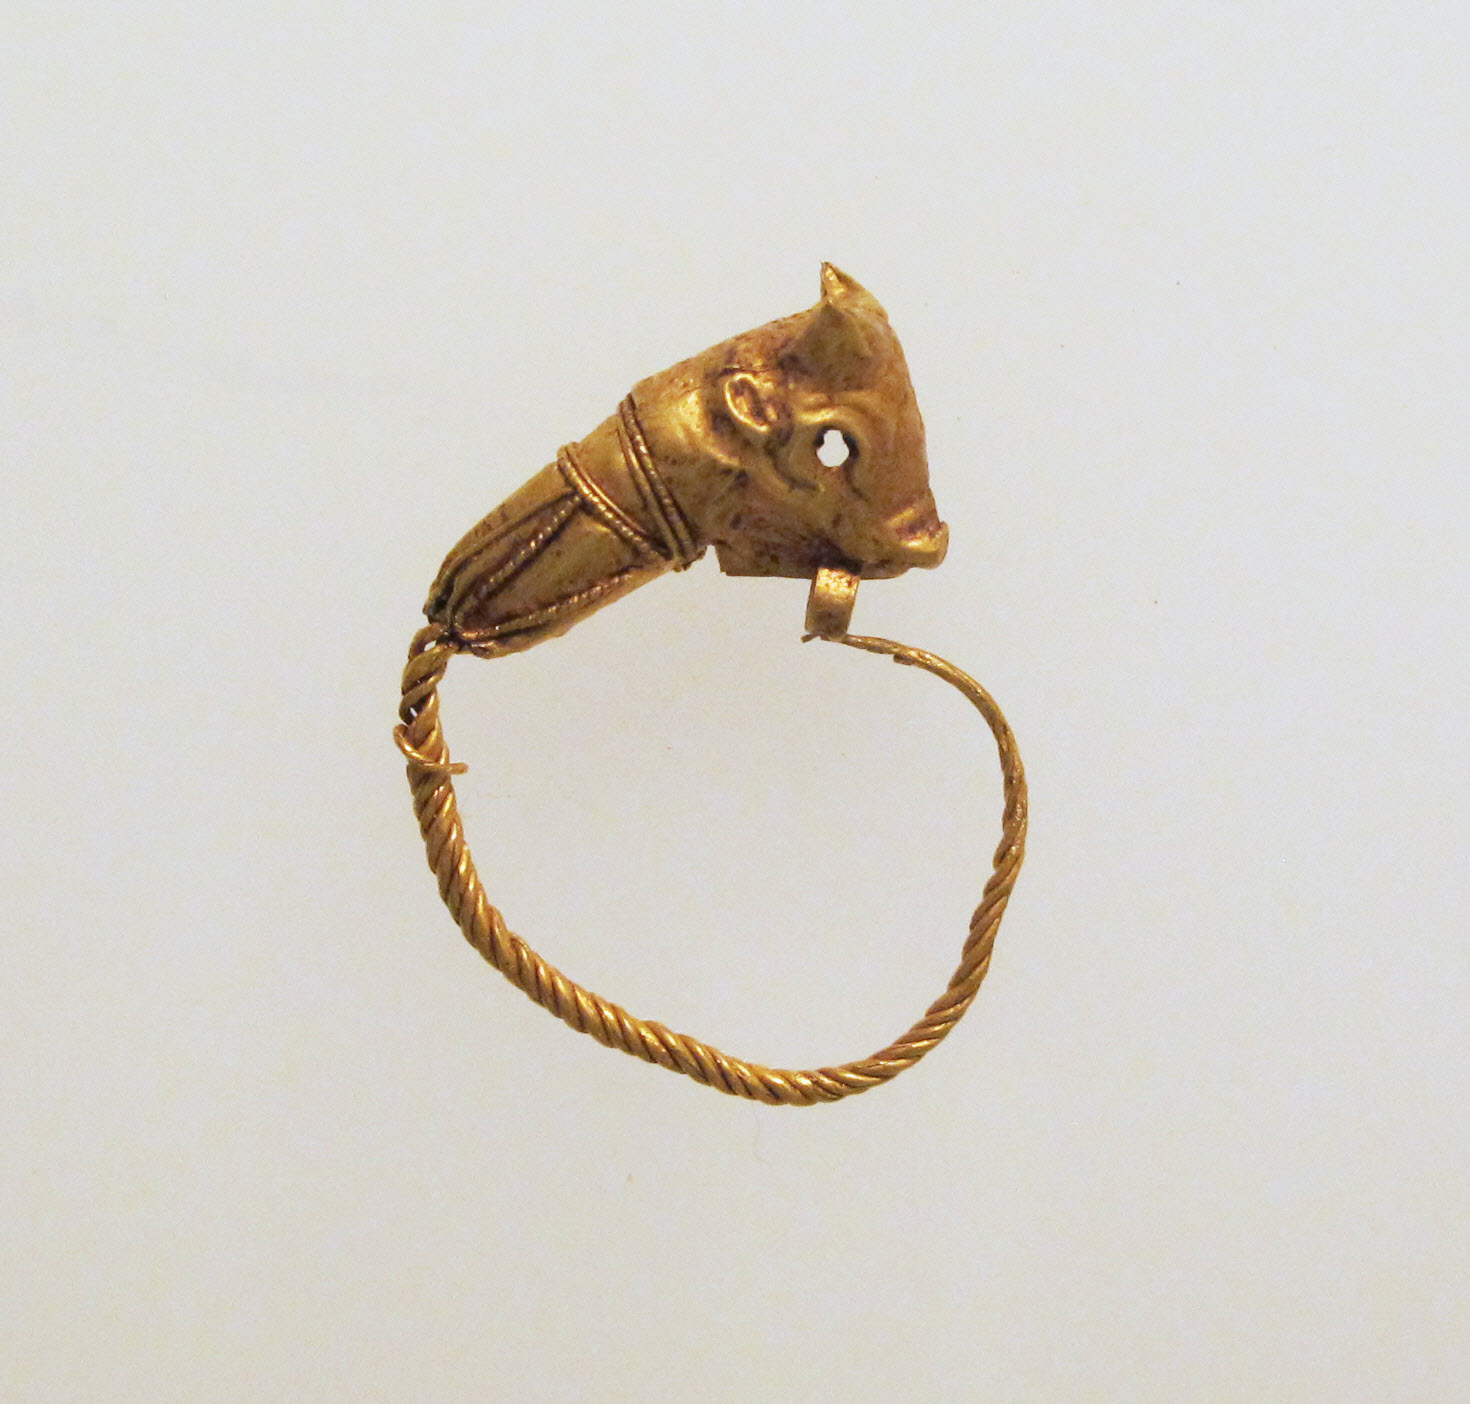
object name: earring with head of bull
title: Gold earring with head of a bull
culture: greek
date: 400-201 BCE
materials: gold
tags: bulls